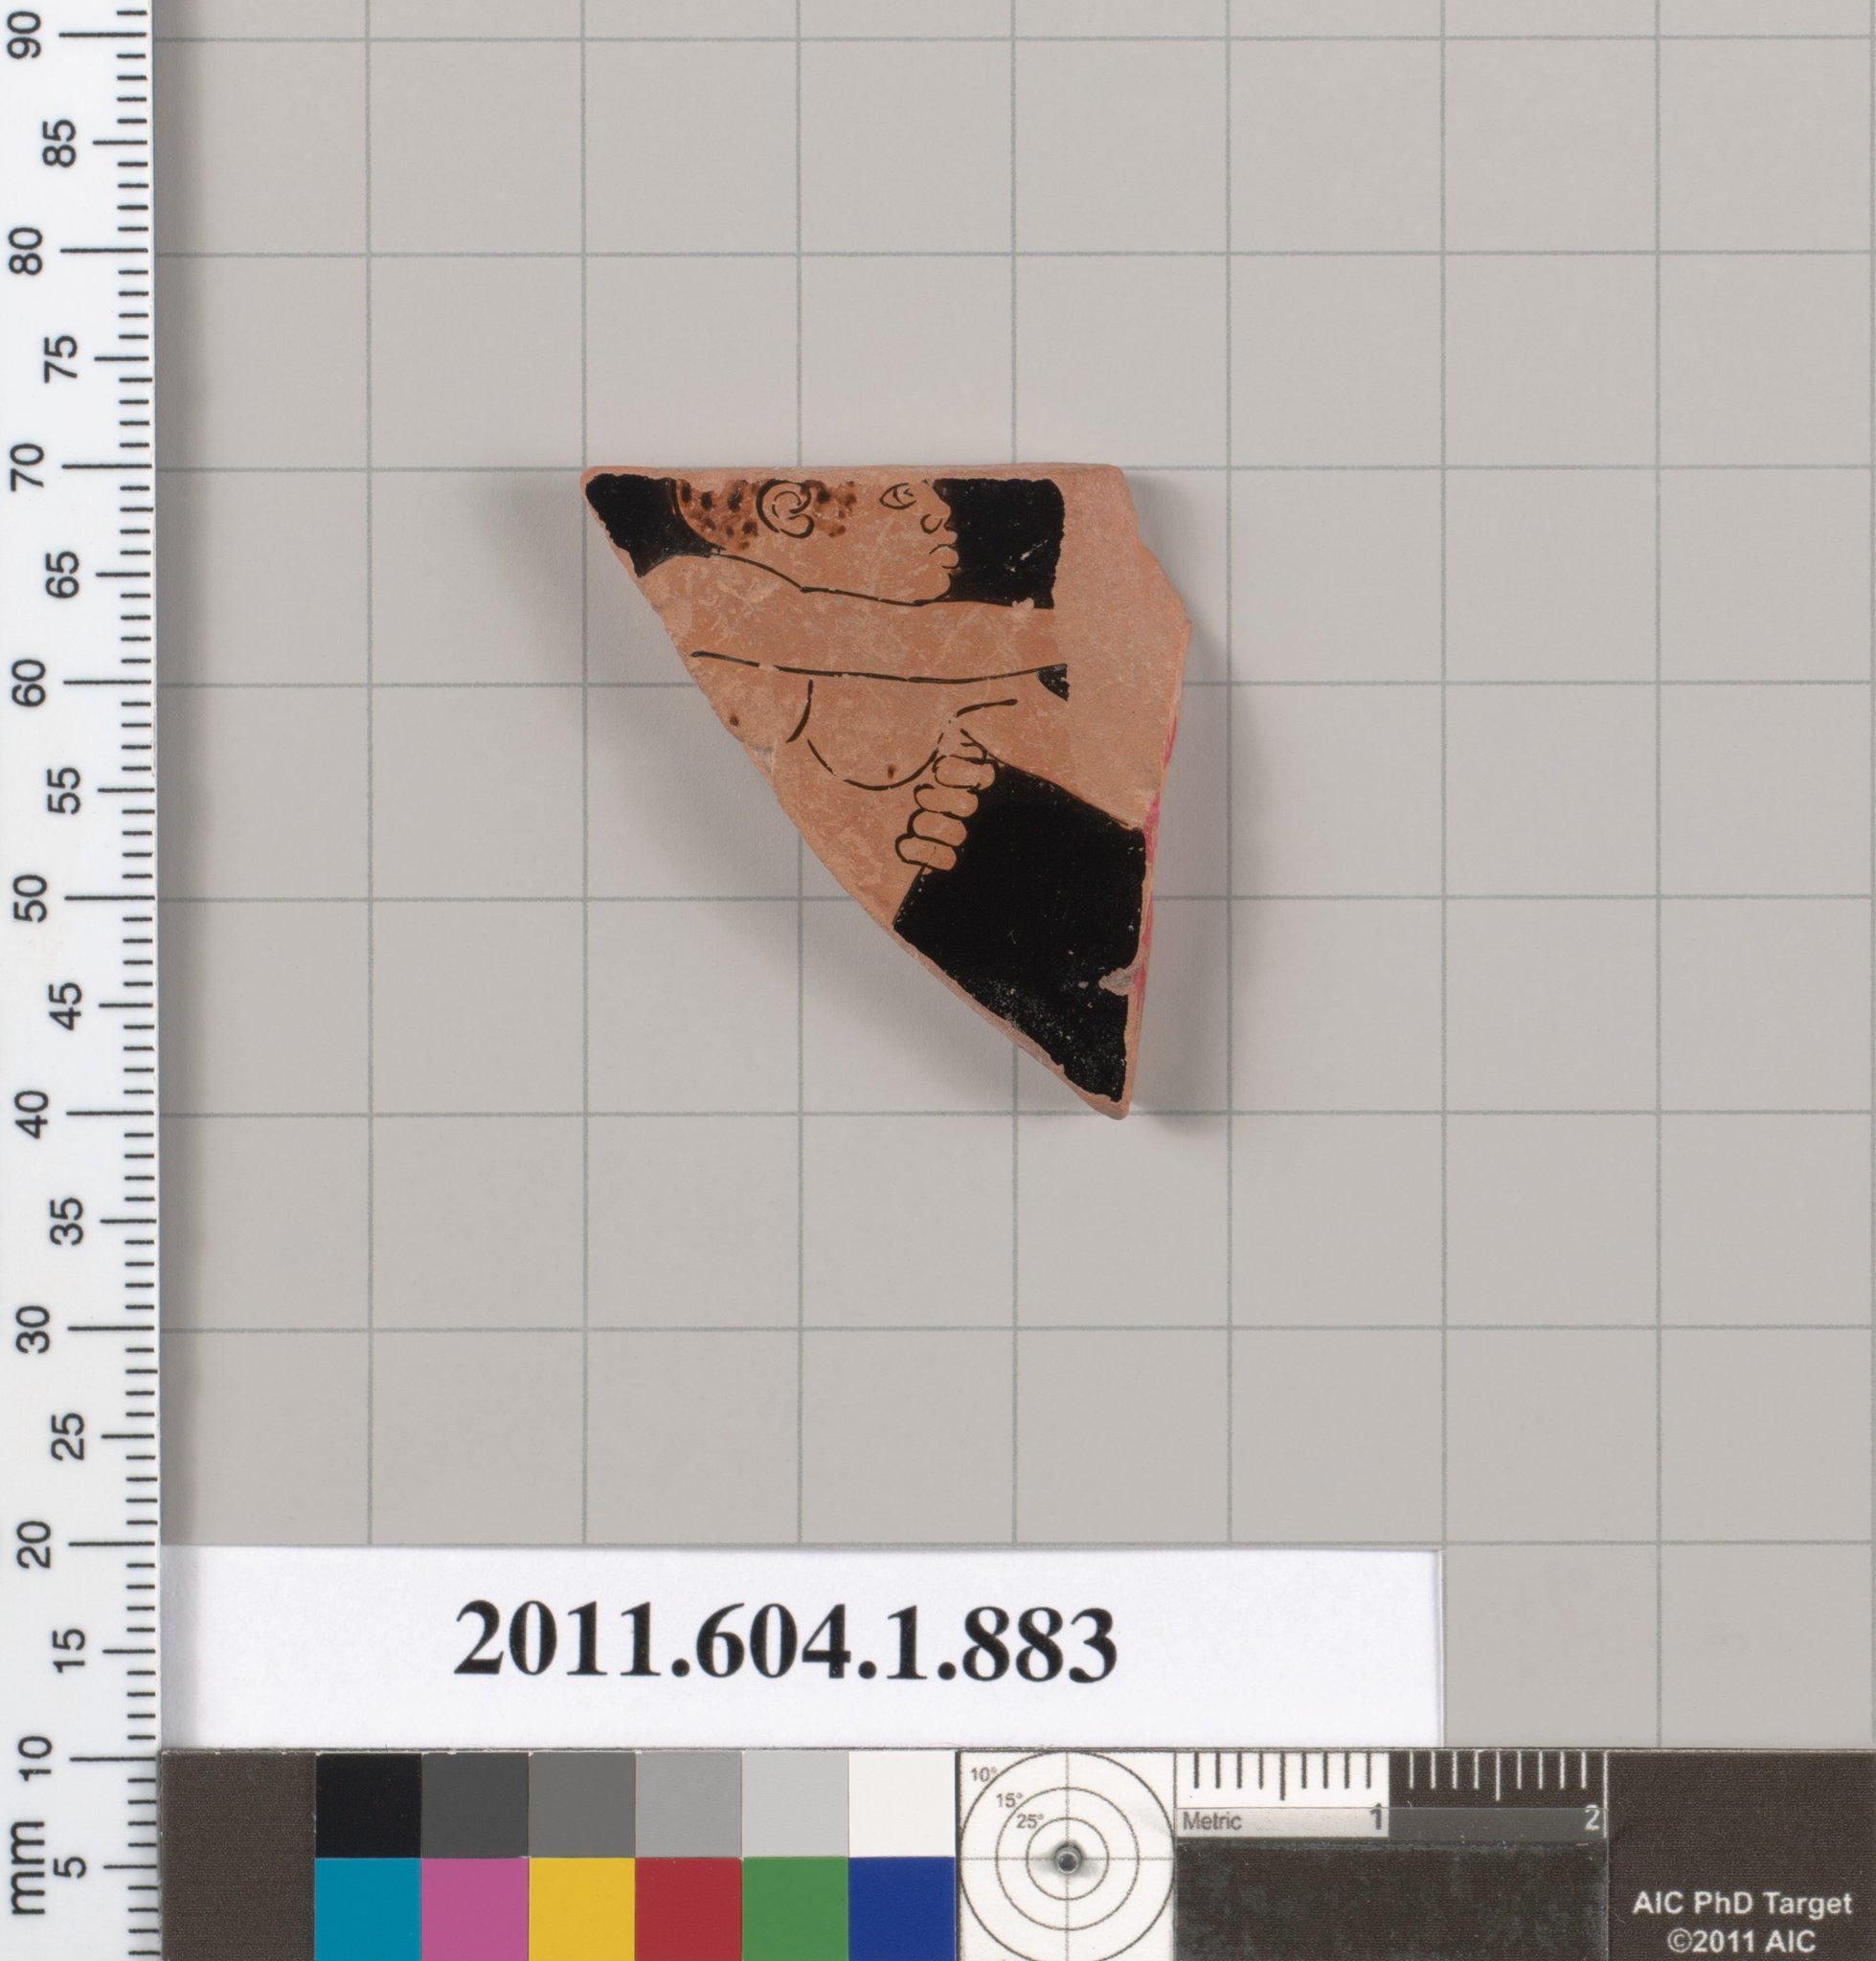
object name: kylix fragment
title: Terracotta fragment of a kylix (drinking cup)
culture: greek, attic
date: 490-480 BCE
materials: terracotta